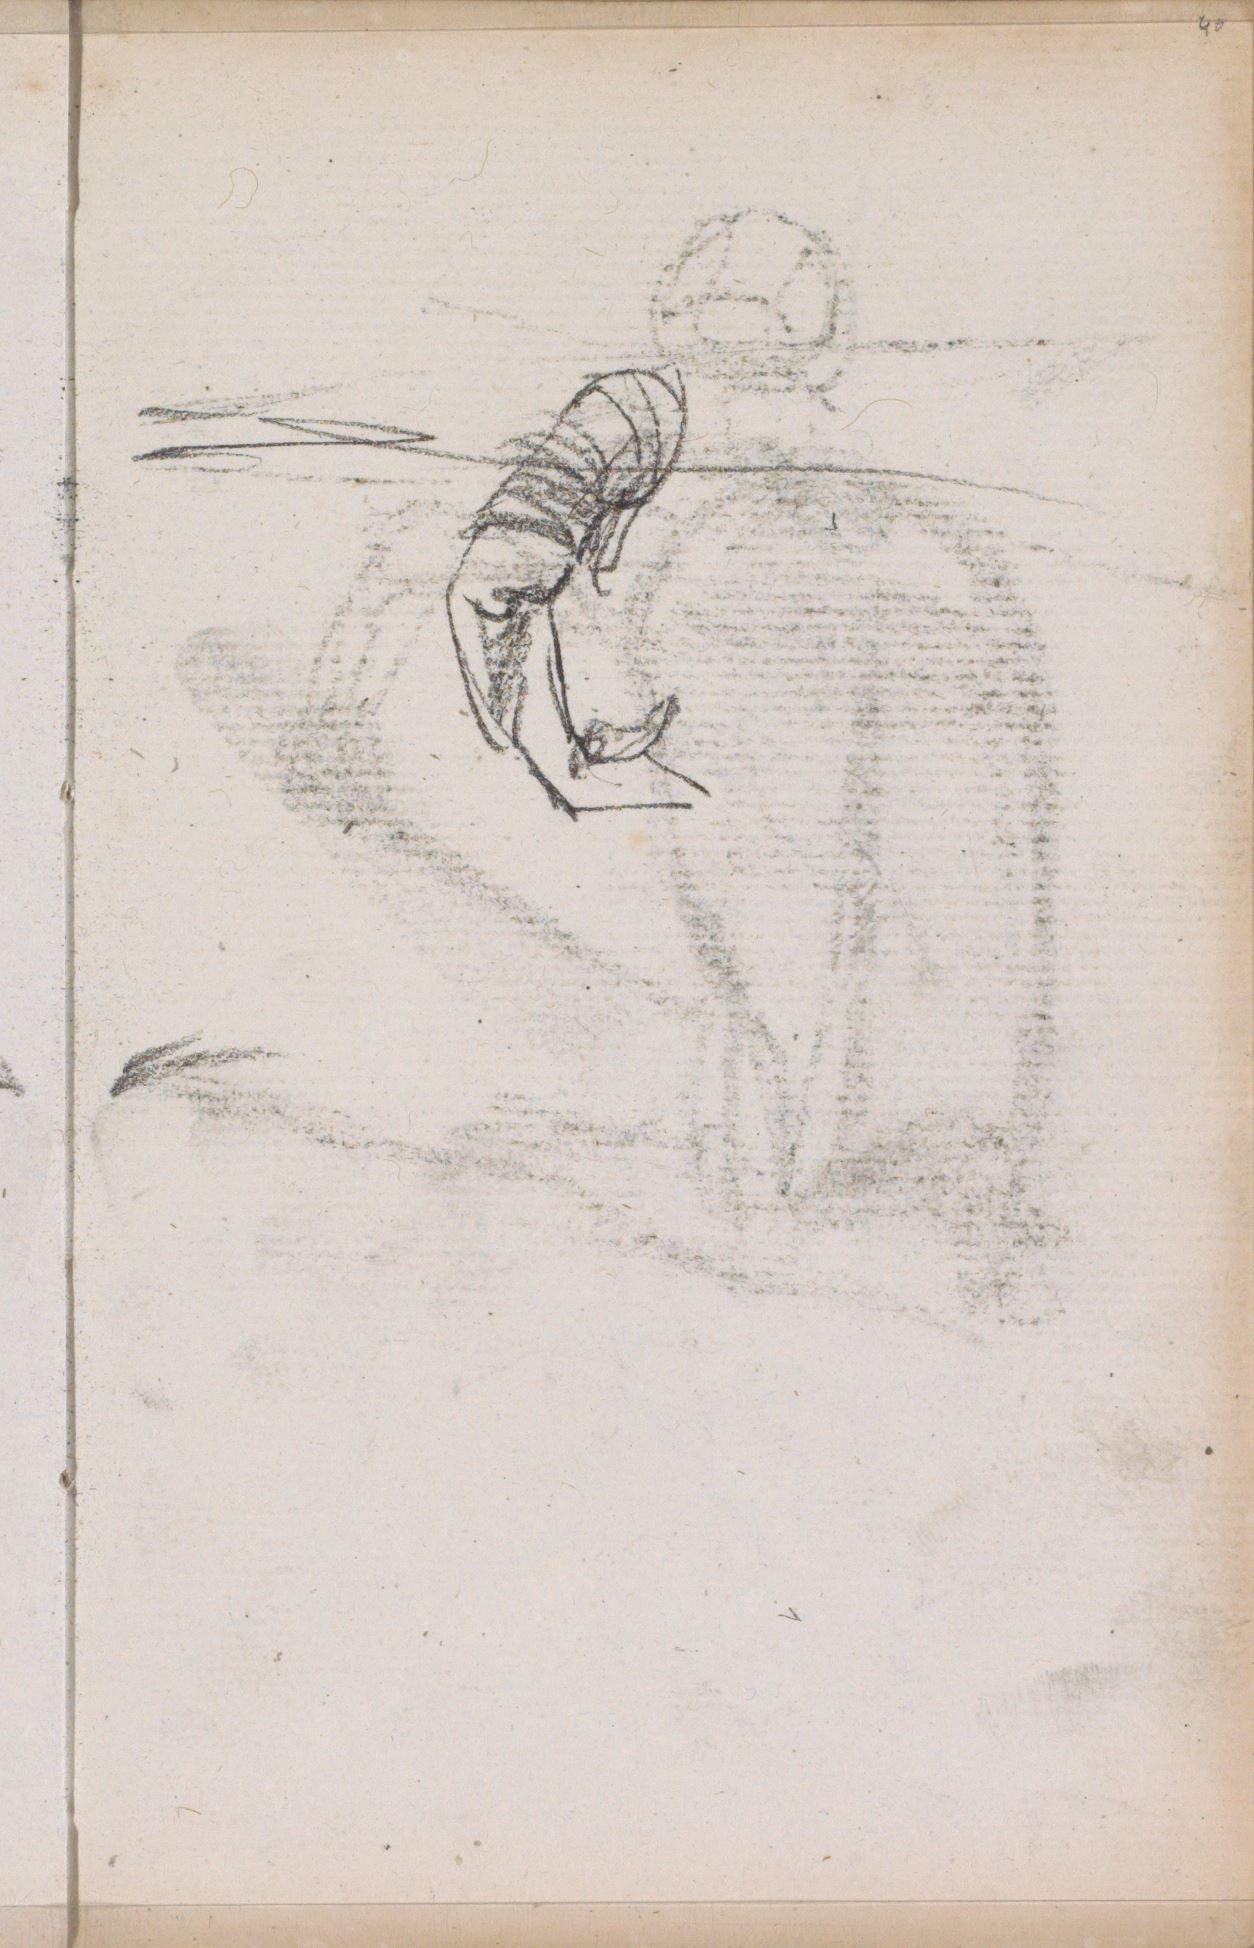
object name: sketchbook leaf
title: Studie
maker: george hendrik breitner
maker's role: draughtsman, painter, print maker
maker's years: 1857-1923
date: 1884-1886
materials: chalk, paper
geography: drenthe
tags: arms, agricultural implements: plough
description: Mogelijk een arm of een ploegschaar. Pagina 40 uit een schetsboek met 67 bladen vervaardigd in Drenthe.